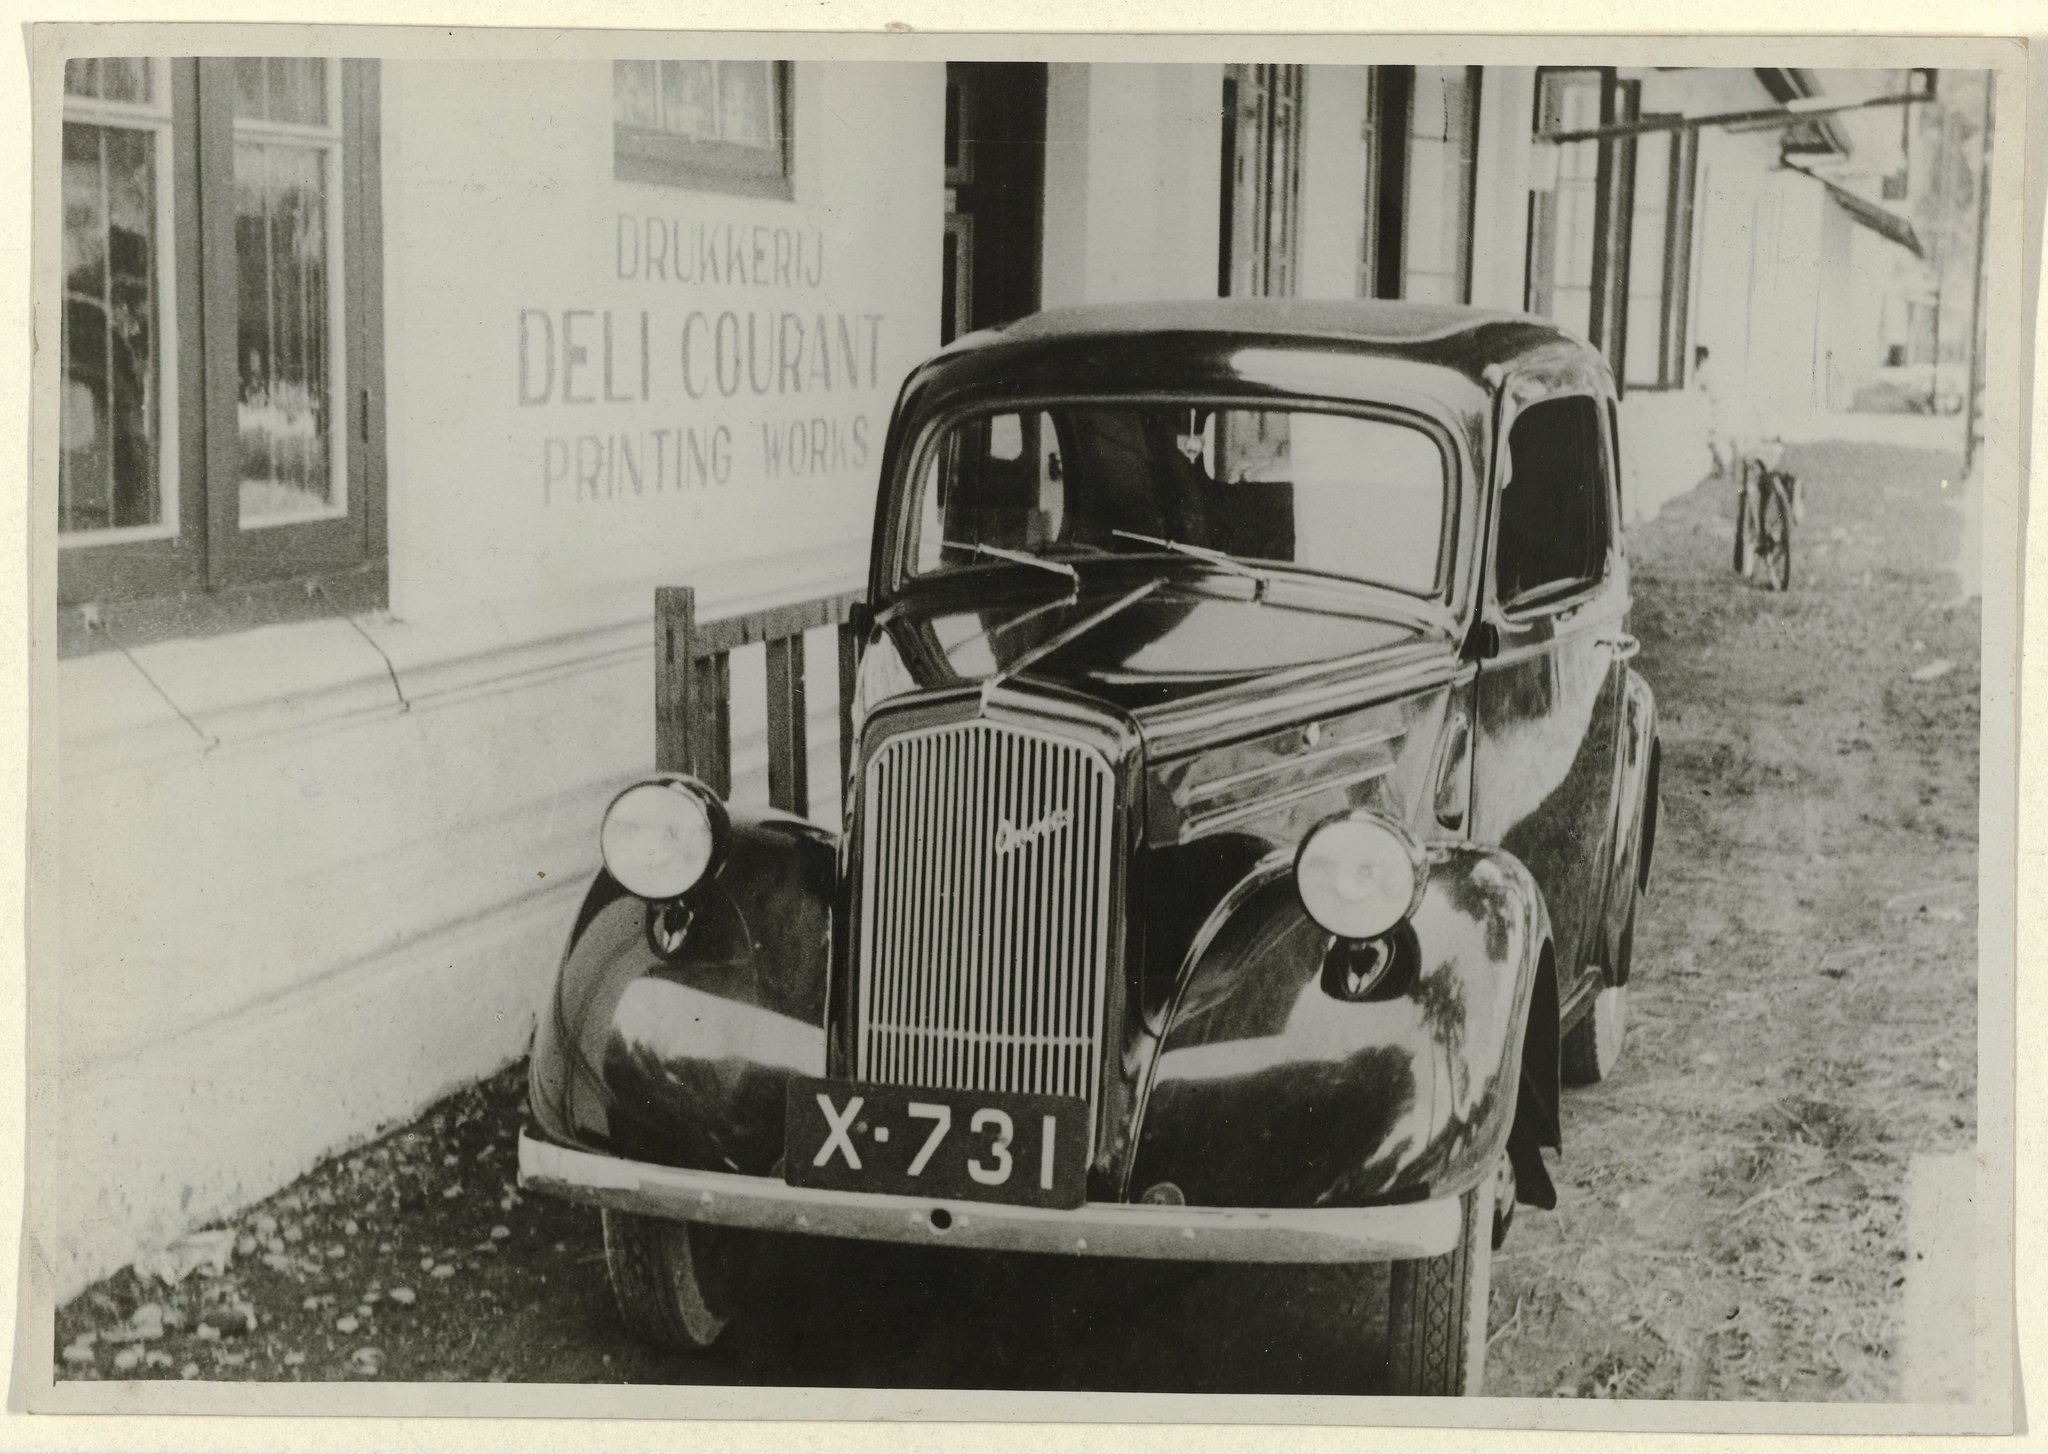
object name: photograph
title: Auto voor de drukkerij van de Deli Courant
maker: Anonymous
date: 1947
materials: photographic support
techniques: collodion silver print, gelatin silver print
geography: medan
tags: dutch east indies, the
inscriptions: stamp: ‘Archief No. AF-29 / Datum: 28 Maart 1947 / Nadruk verboden / Iedere reproductie van deze foto zonder toestemming hoofd L.V.D. te Medan is verboden. / Copyright Foto Afd. L.V.D. - Medan’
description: Een auto geparkeerd voor de drukkerij van de Deli Courant, 28 maart 1947. Onderdeel van een groep van 49 losse zwart-wit foto's van verschillend formaat over de uitgeverij en drukkerij van de krant Deli Courant in Medan in de periode 1885-1947.